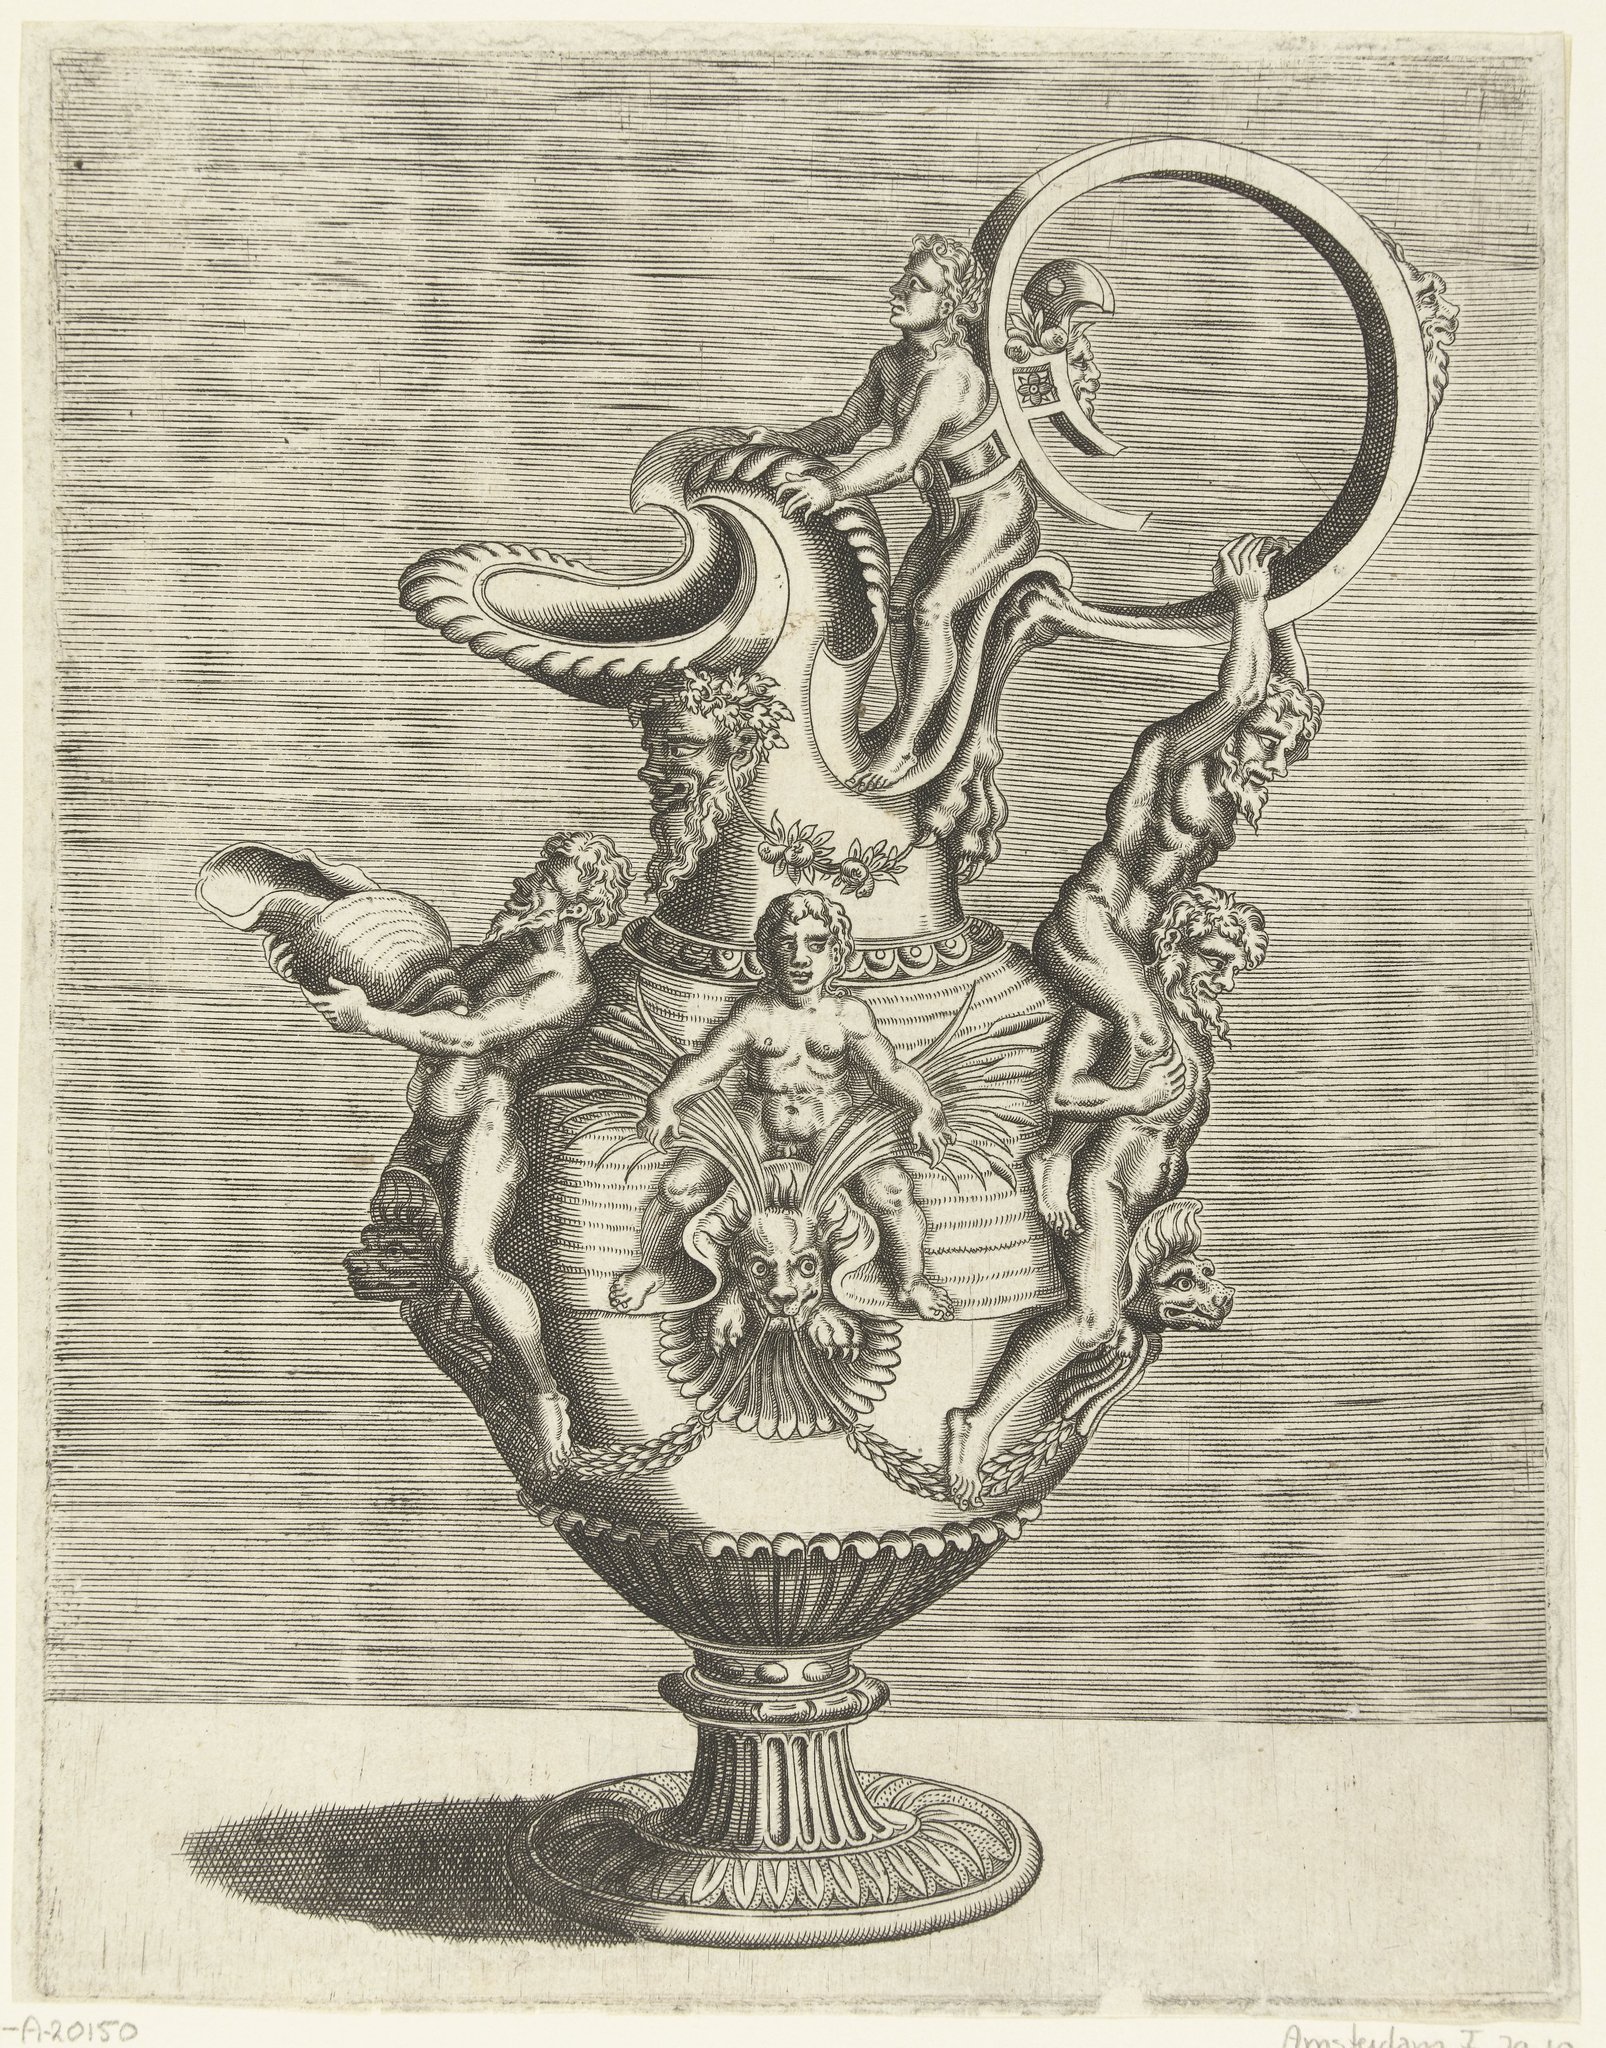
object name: ornament print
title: Kan, het oor is aan de bovenzijde bevestigd aan de rug van een vrouw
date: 1548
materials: paper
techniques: engraving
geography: netherlands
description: Kan met oor. Aan de bovenzijde is het oor bevestigd aan de rug van een vrouw die bij de opening staat. Aan het oor hangt een man, op de schouders genomen door een tweede man, die op een mascaron zit dat aan de buik van de kan hangt. Afkomstig uit een serie bestaande uit een titelblad en 20 bladen.